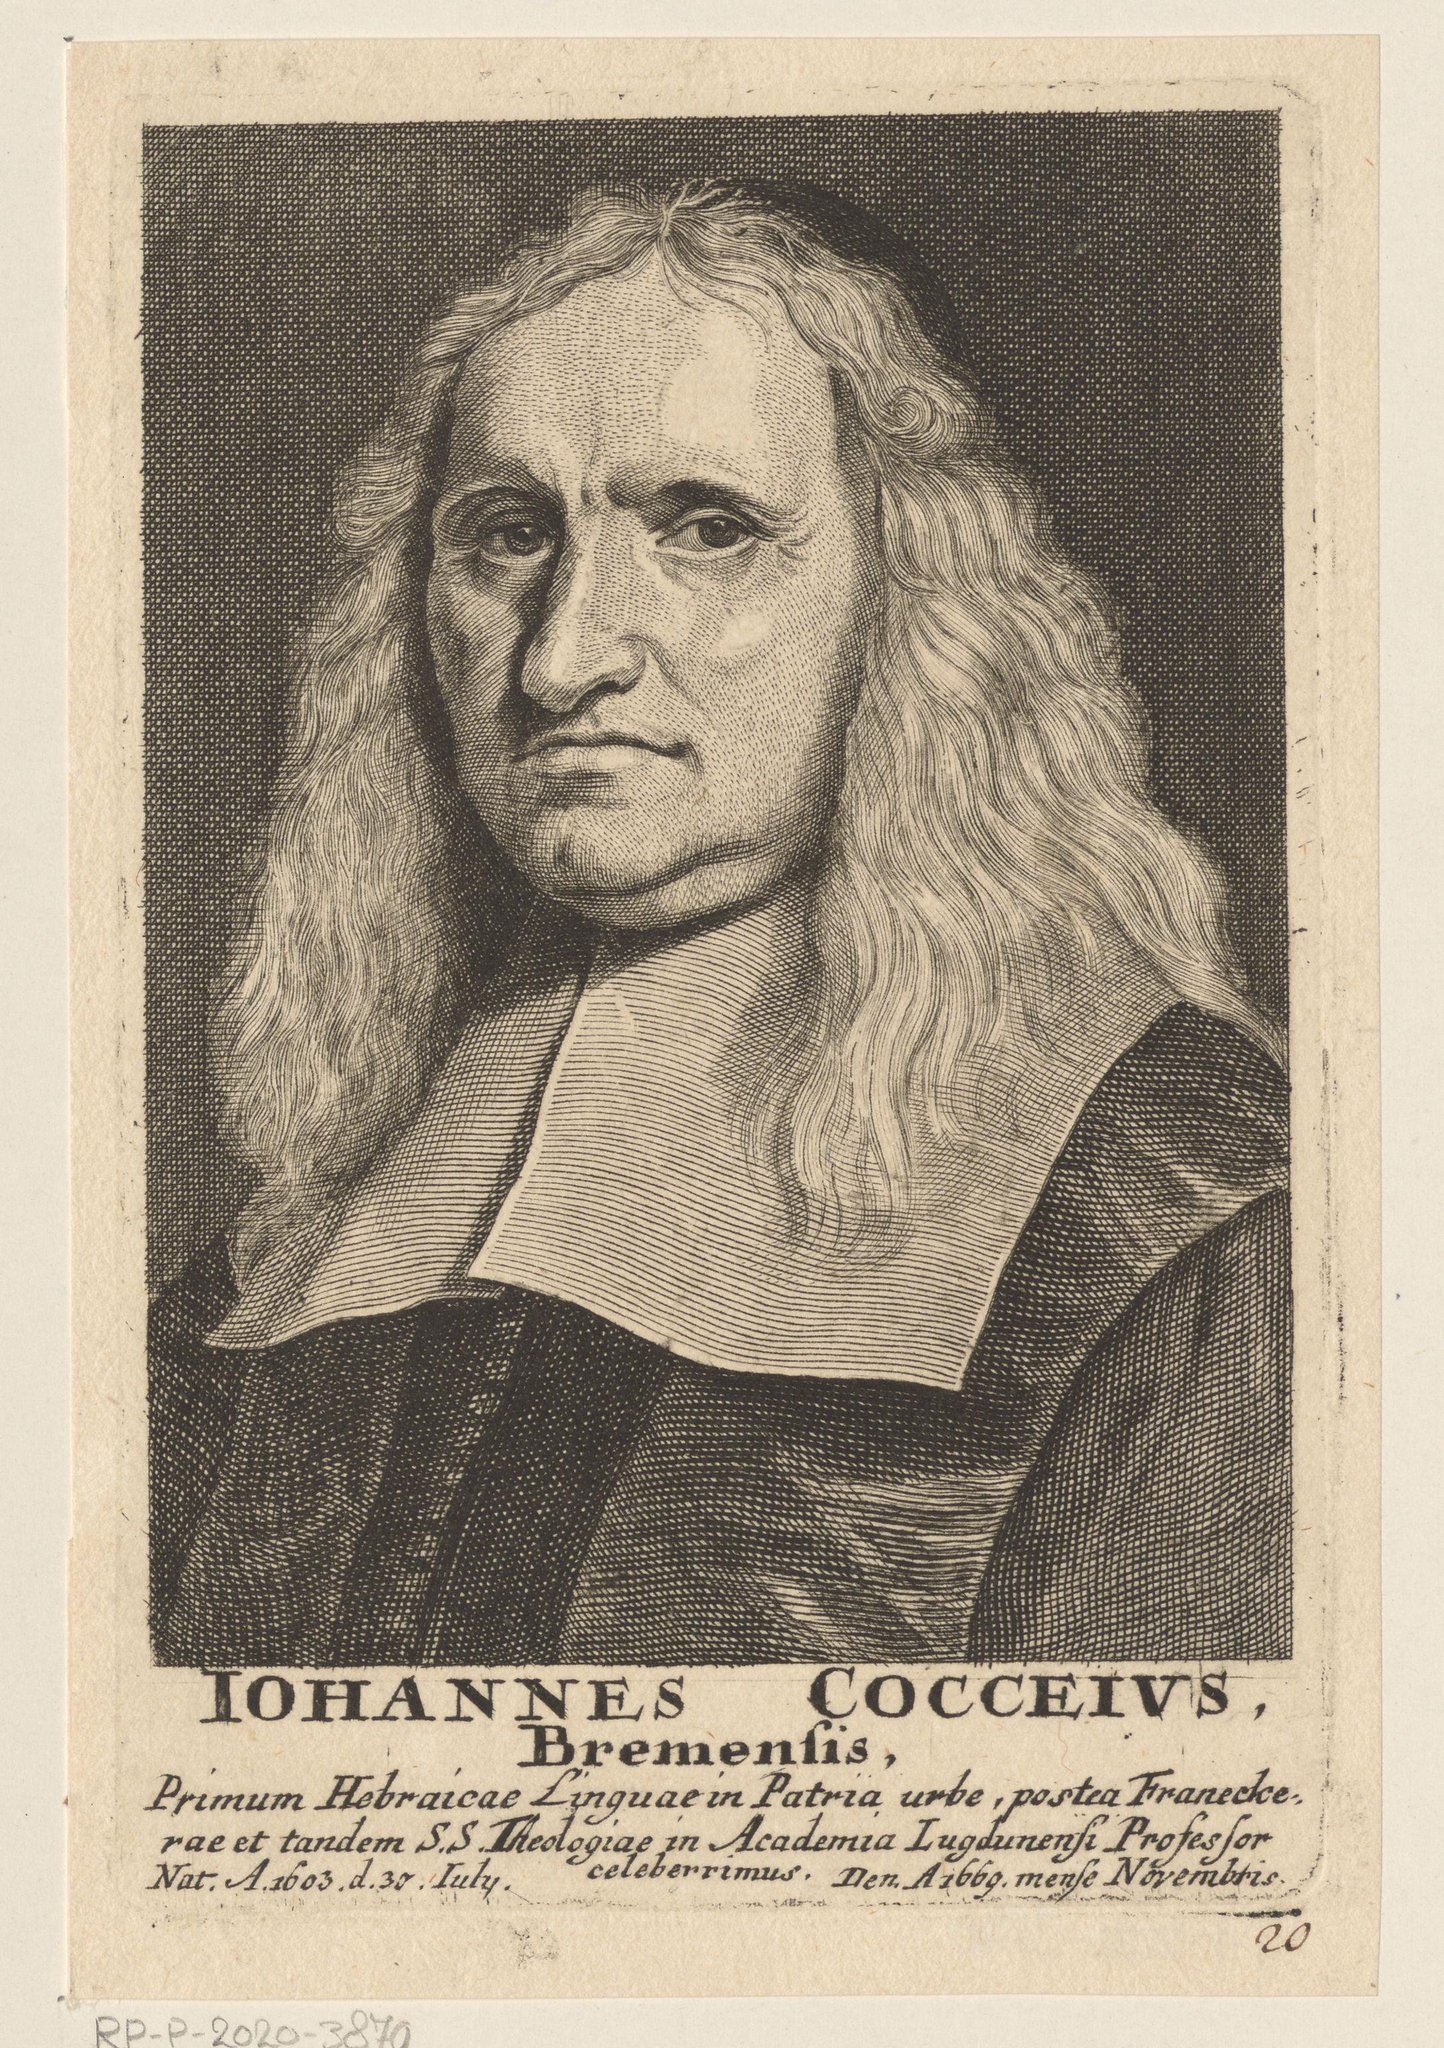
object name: print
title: Portret van Johannes Cocceius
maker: Anonymous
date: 1669-1699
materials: paper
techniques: engraving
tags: historical persons